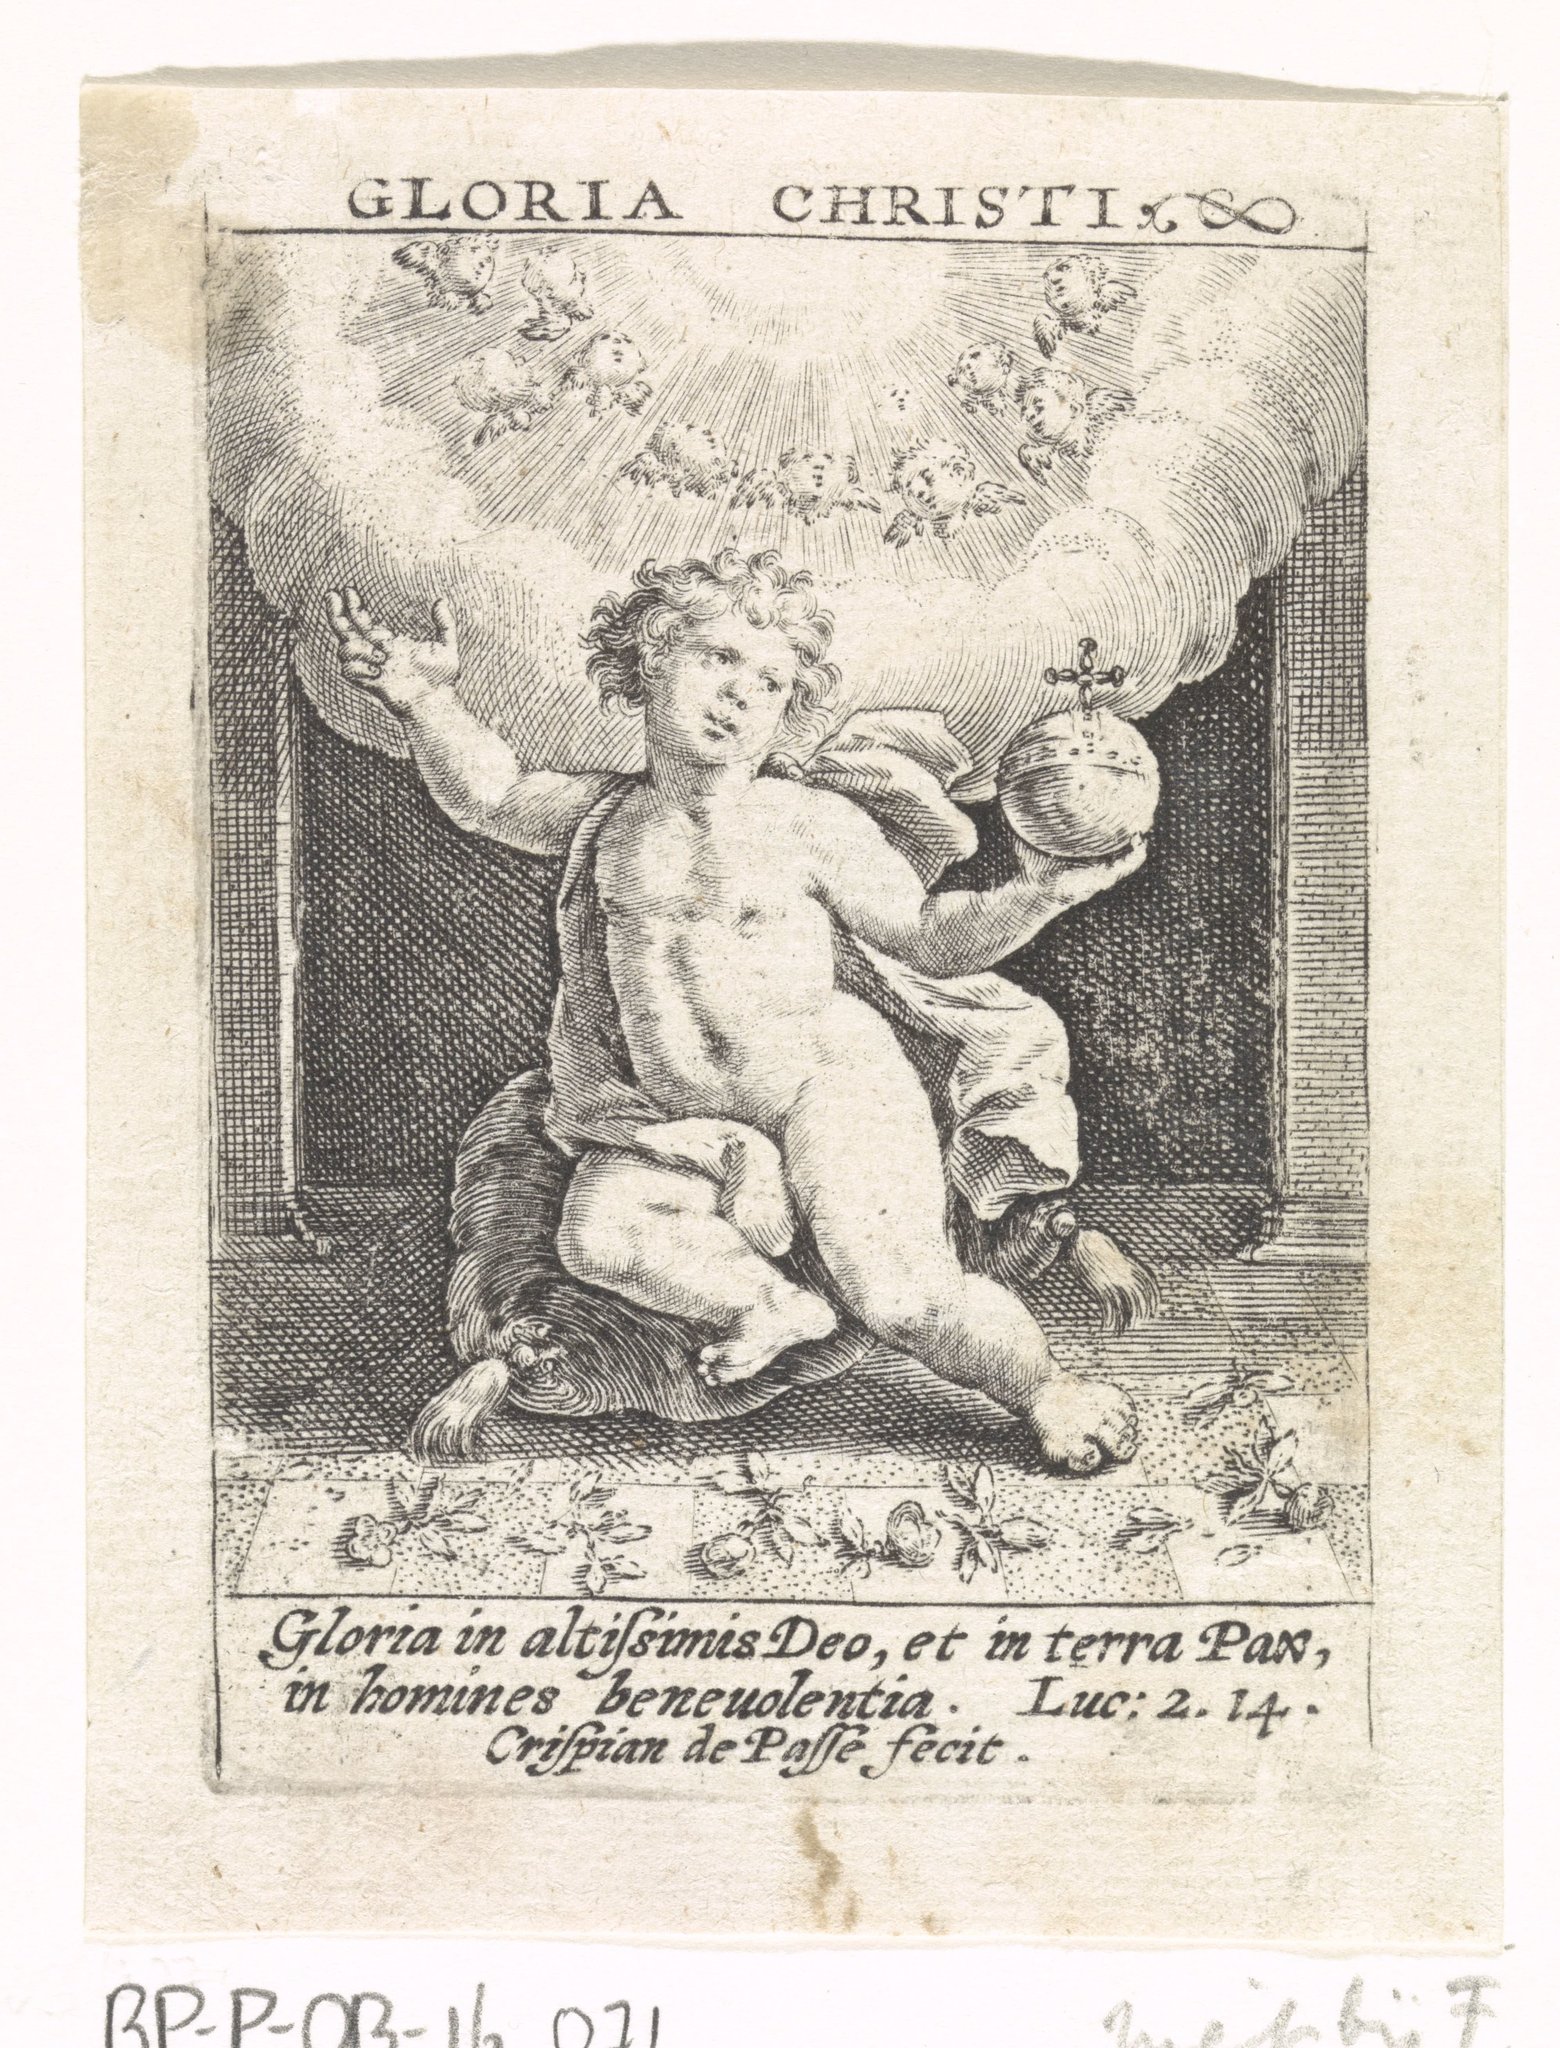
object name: print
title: Christuskind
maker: crispijn van de passe (i)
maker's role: draughtsman, print maker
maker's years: 1564-1637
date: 1574-1637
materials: paper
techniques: engraving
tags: christ-child (with attributes)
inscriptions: collector's mark: Lugt 2228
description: Het Christuskind, zittend op een kussen, bloemen aan zijn voeten. In de hemel boven hem een kring van cherubijnen. In de marge een tweeregelig Bijbelcitaat uit Luc. 2:14 in het Latijn.